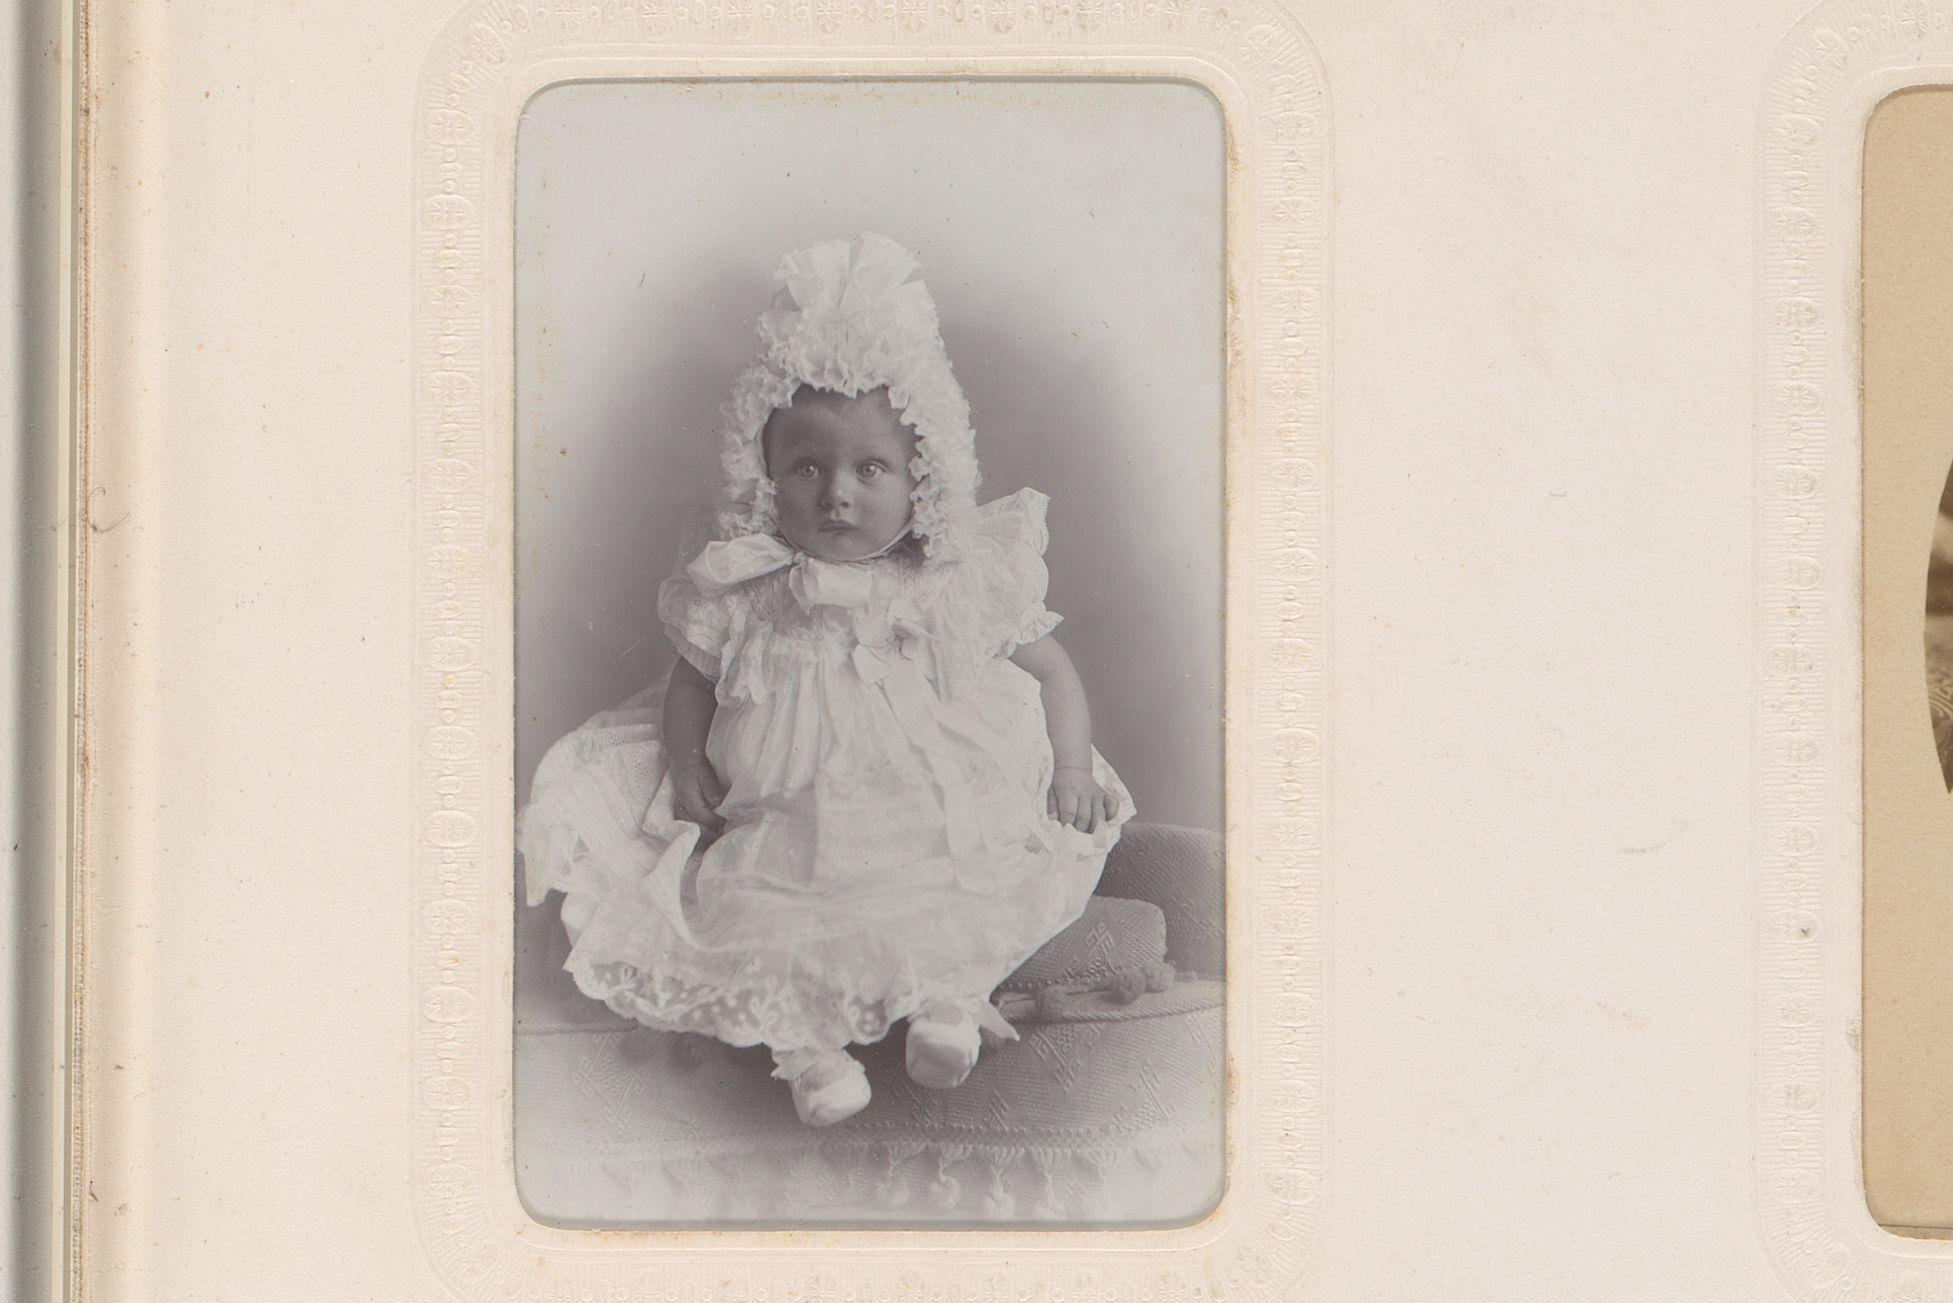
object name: album leaf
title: Portret van een meisje en een jongen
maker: Anonymous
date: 1880-1920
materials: cardboard, photographic support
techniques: collodion silver print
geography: netherlands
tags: historical persons - bb - woman, boy (child between toddler and youth), historical persons, toddler (female)